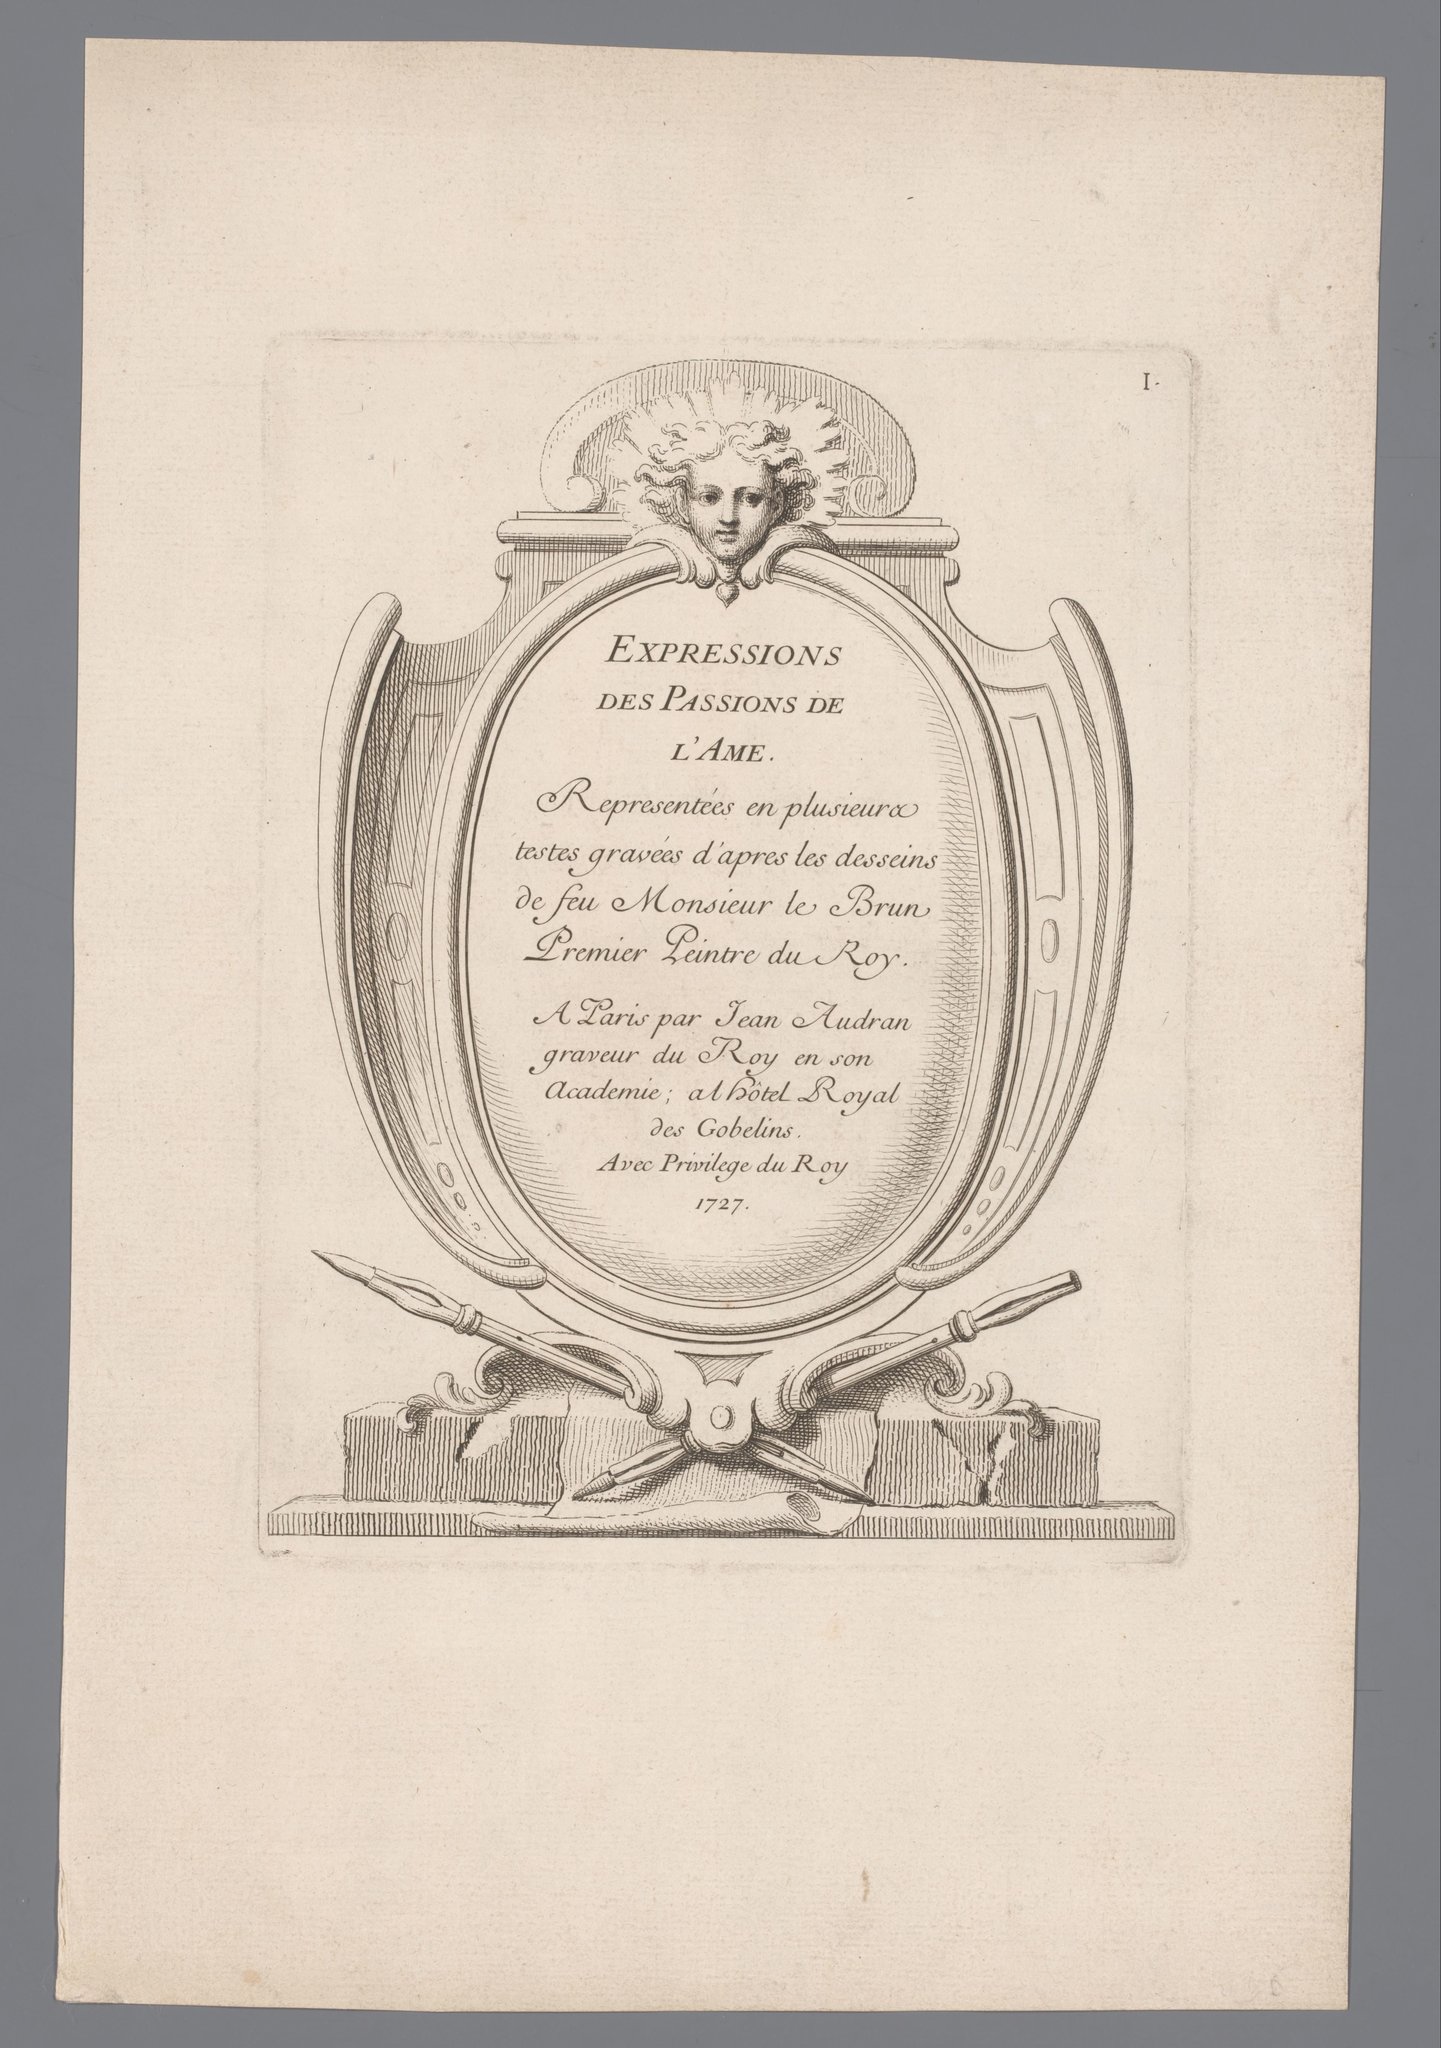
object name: print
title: Uitdrukkingen van de passies van de ziel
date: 1727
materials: paper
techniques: etching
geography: paris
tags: morphology of facial expression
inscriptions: collector's mark: Lugt 2228